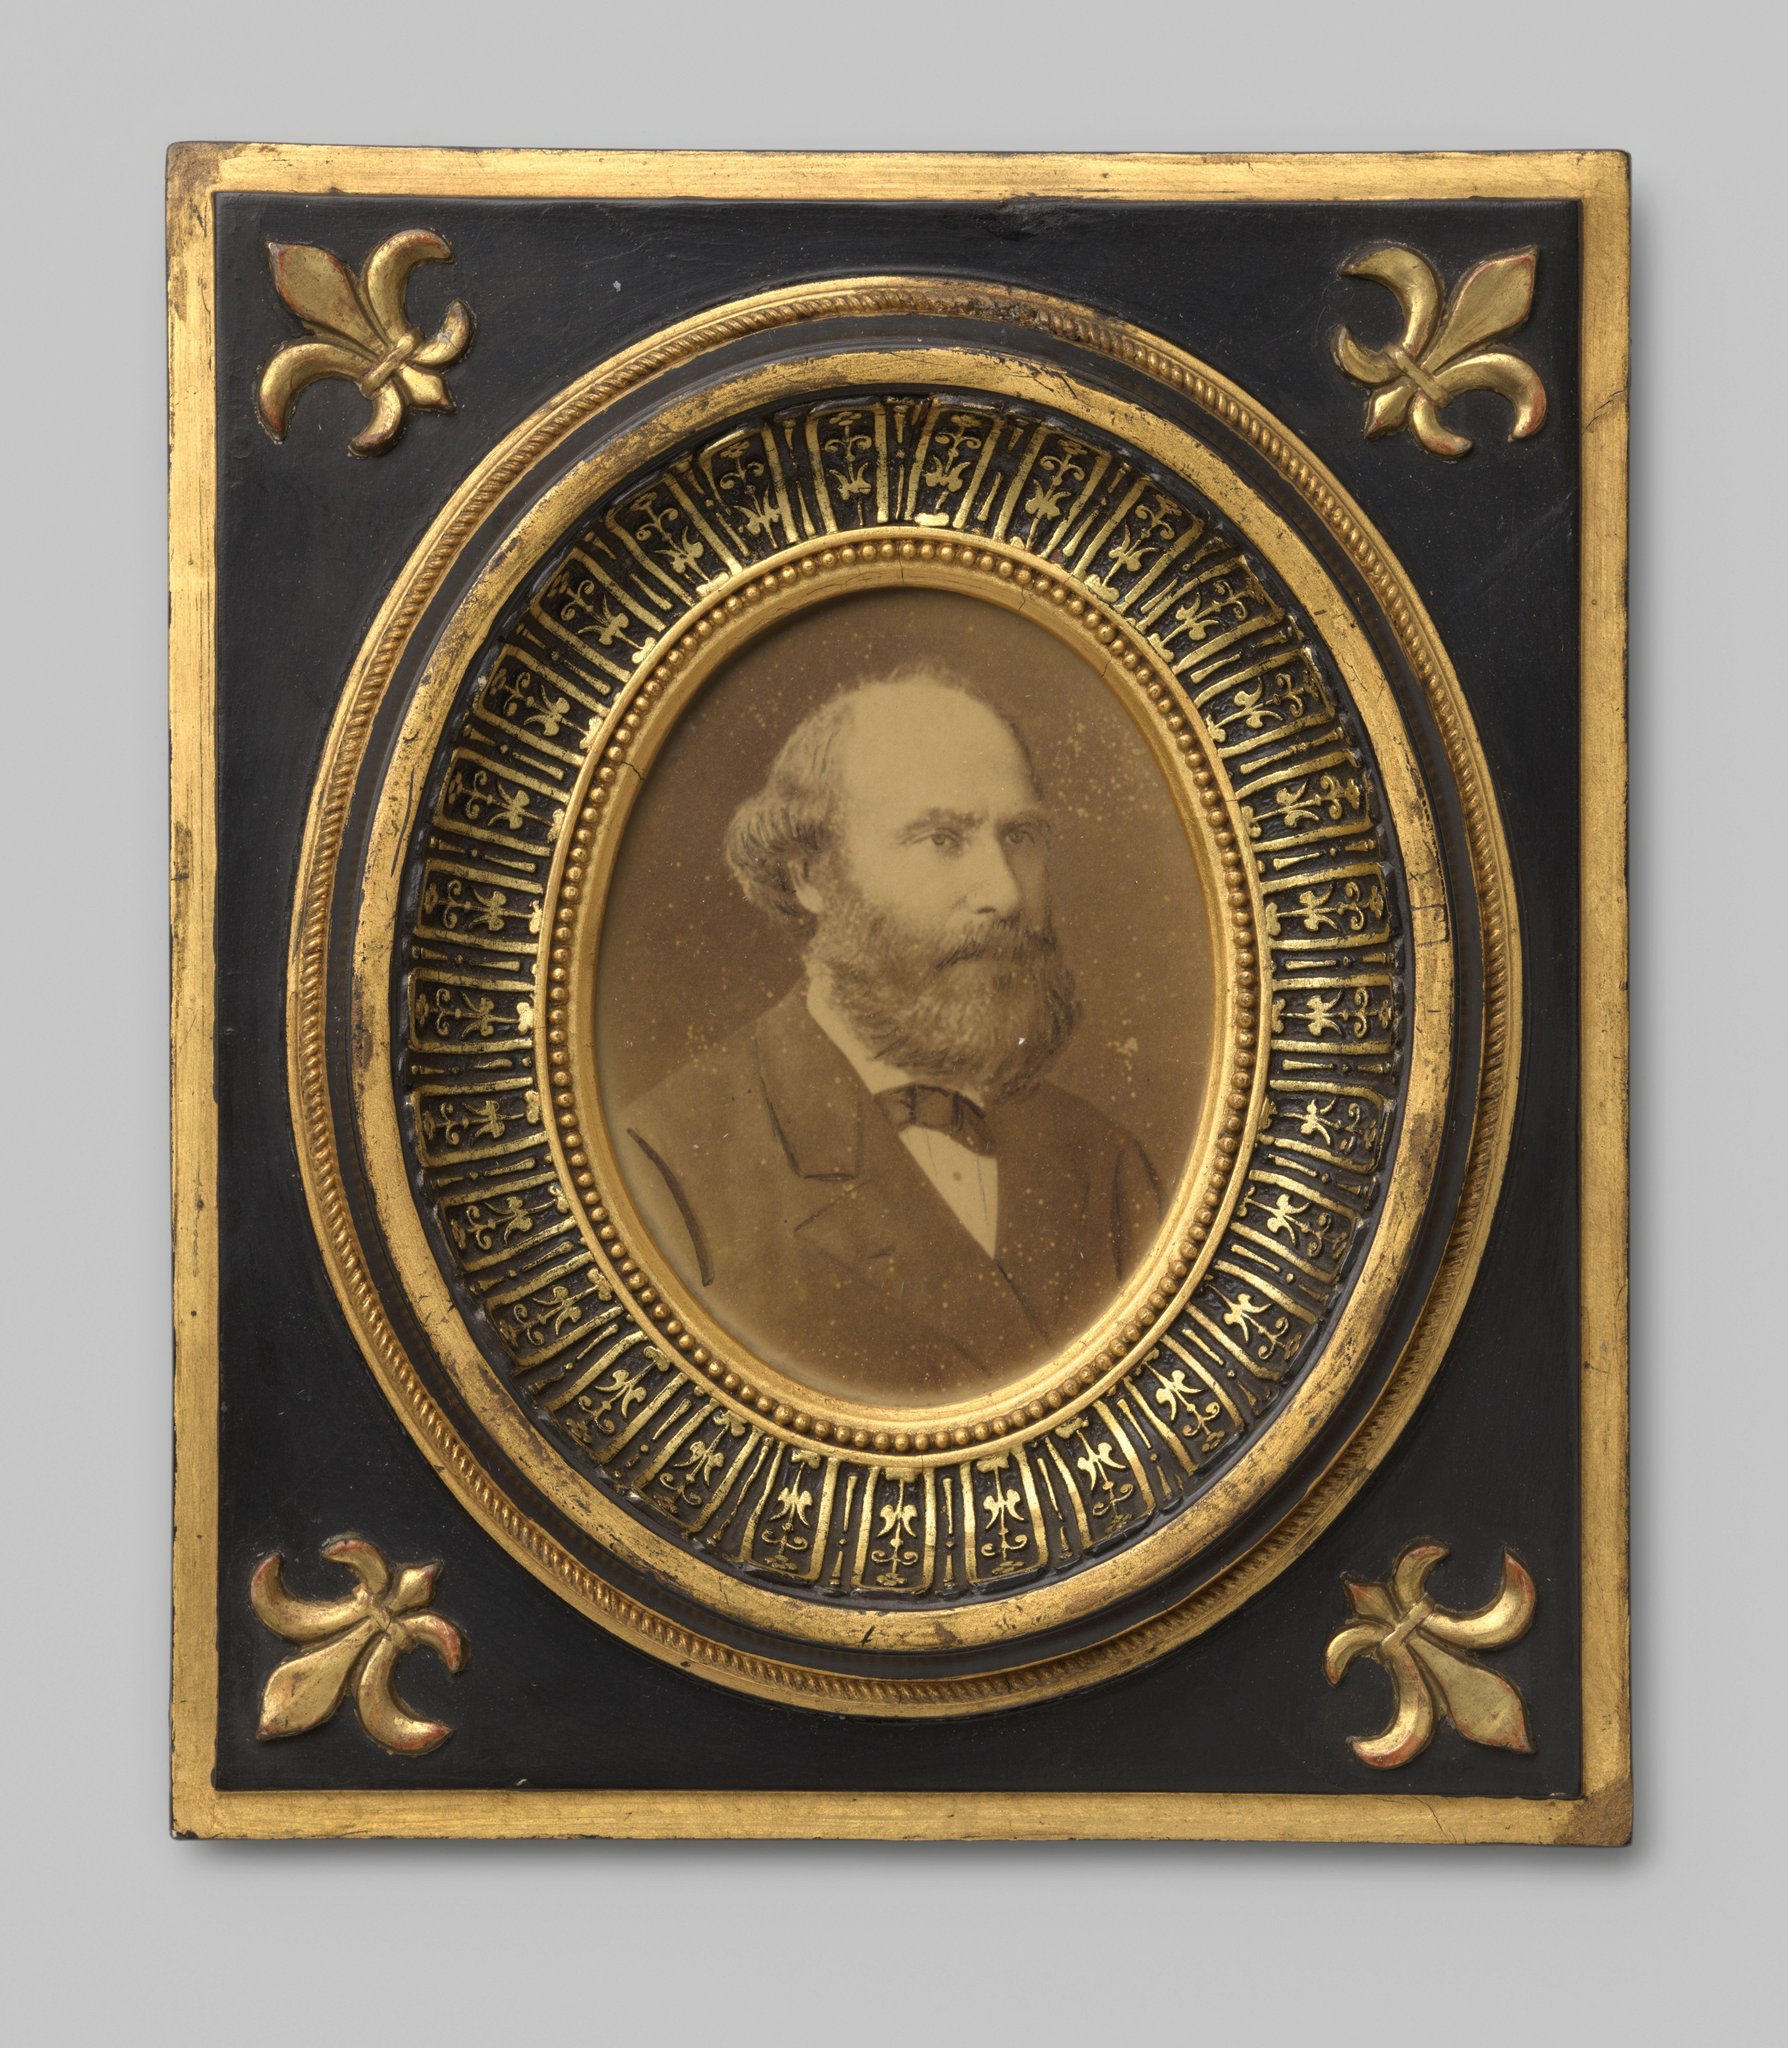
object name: frame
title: Portret van een onbekende man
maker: elkan sanders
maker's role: fotograaf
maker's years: 1848-1923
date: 1860-1890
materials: cardboard, glass, metal, paper, wood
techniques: albumen print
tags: adult man, anonymous historical person portrayed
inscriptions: label: ‘ATELIER DE PHOTOGRAPHIE/ SPECIALITÉ/ DE/ GRANDES PORTRETS/ AUX DEUX CRAYONS/ AGRONDISSEMENTS/ EN TOUS GENRES/ ELKAN/ RUE PELLART/ ROUBAIX/ PORTRAITS/ D'APRÈS DÉCÉS/ PROCÉDÉ EXTRA RAPIDE/ POUR PHOTOGRAPHIER/ LES ENFANTS’